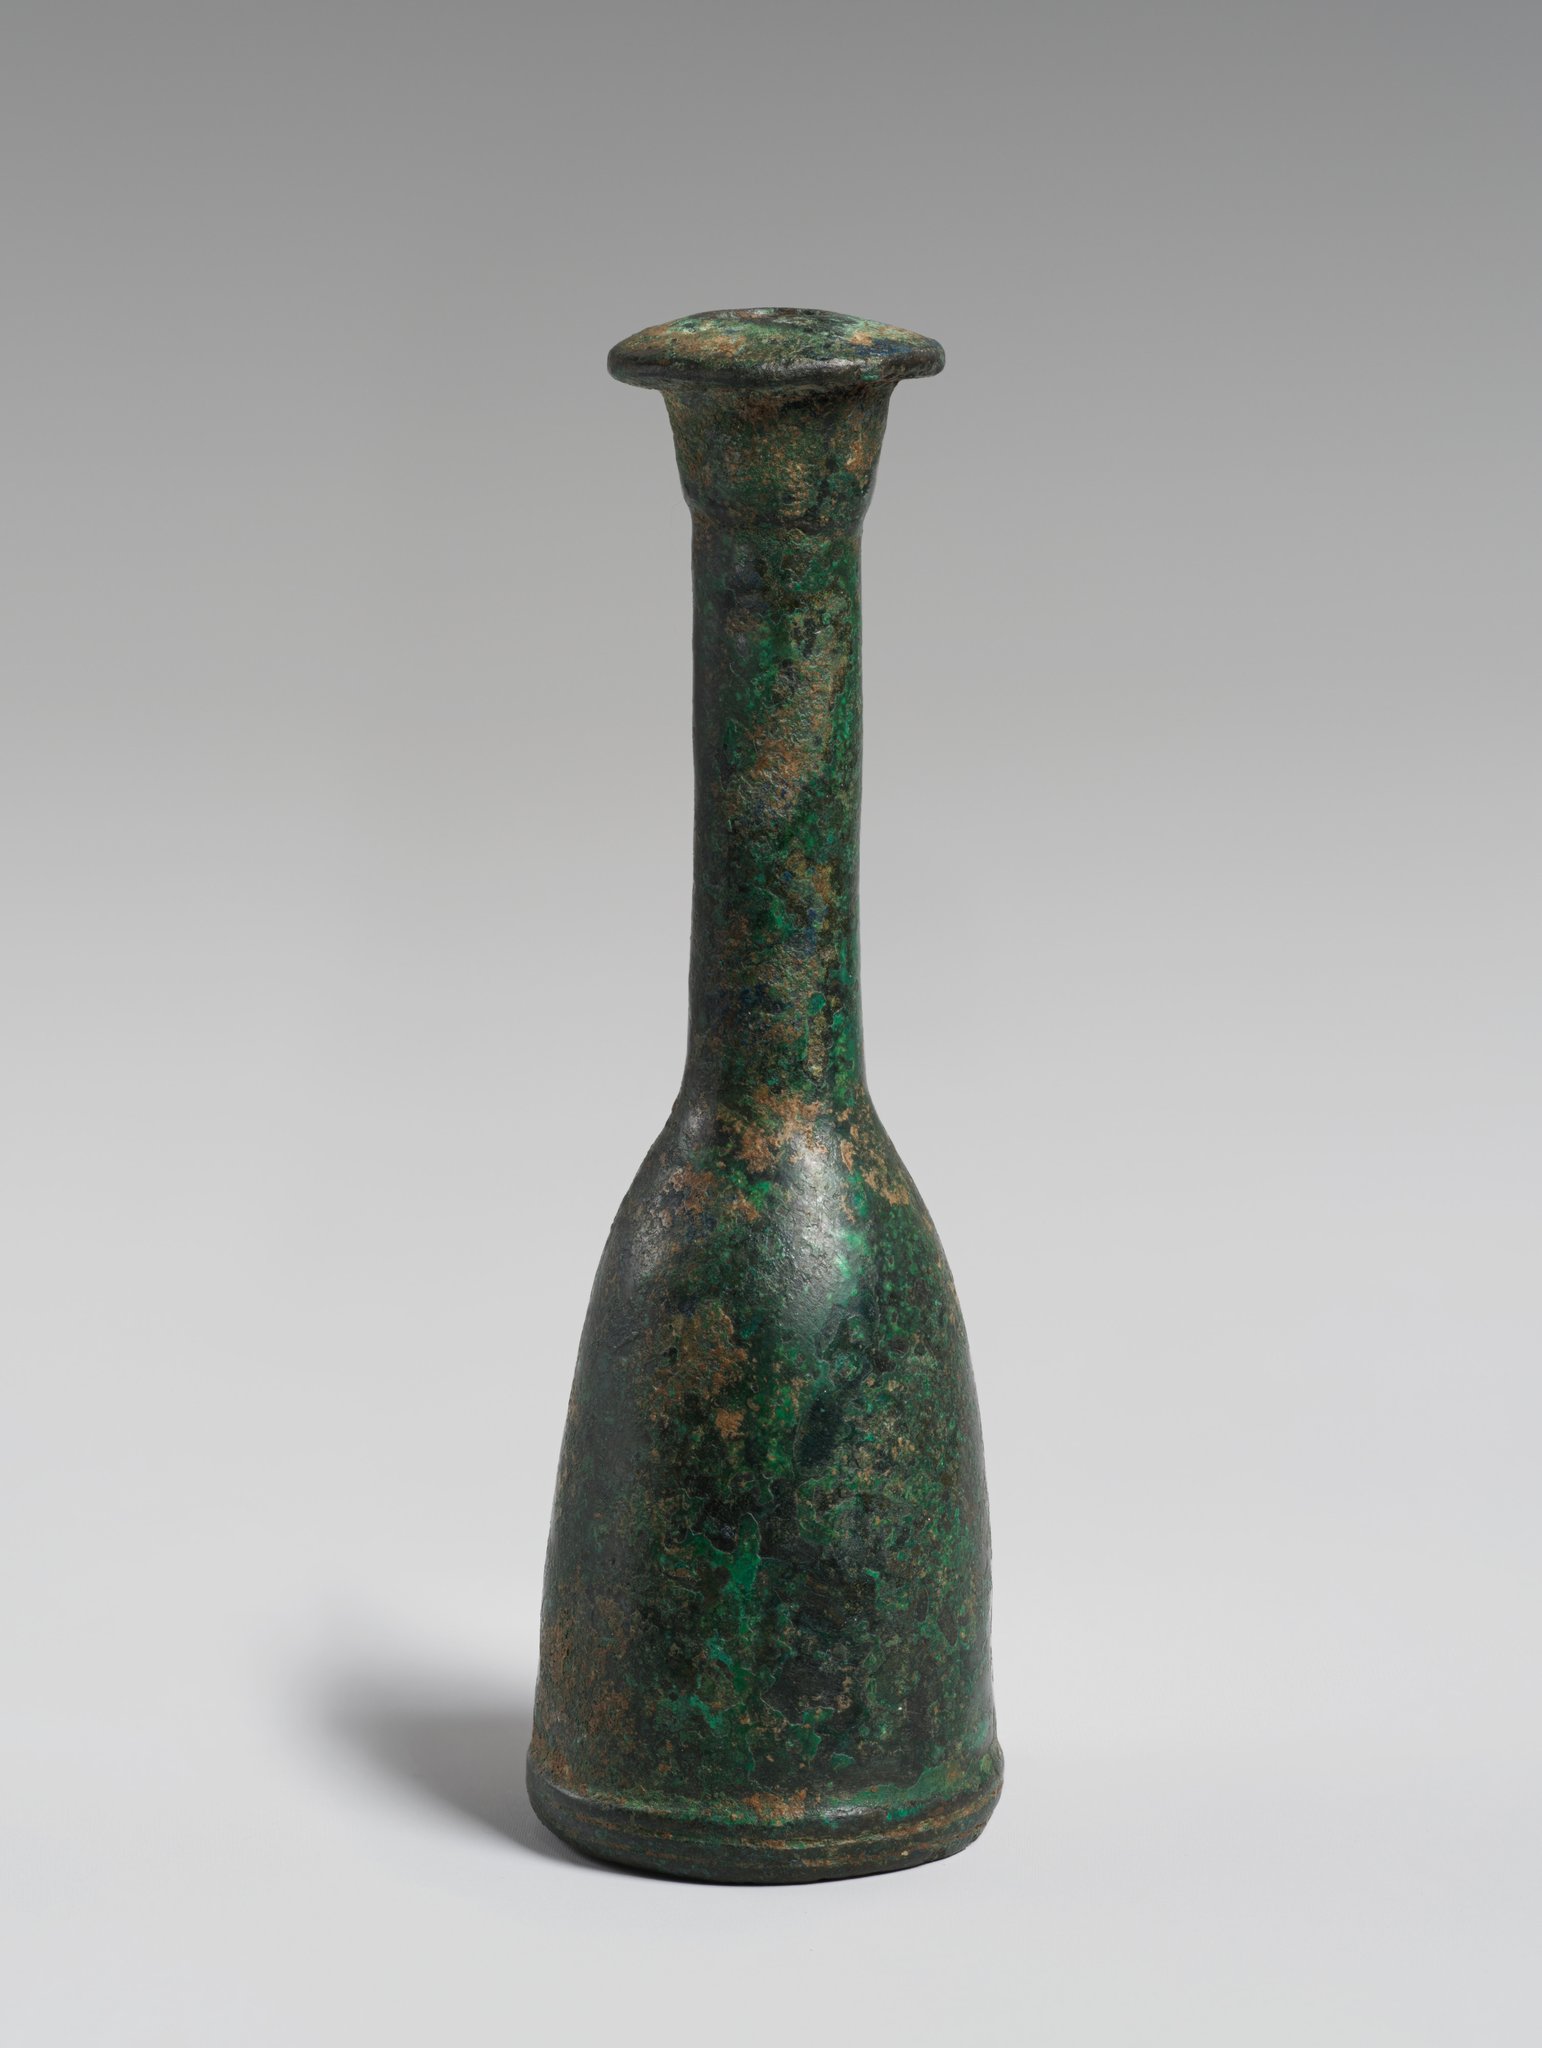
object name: standard support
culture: iranian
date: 800-601 BCE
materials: bronze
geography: iran, probably from luristan